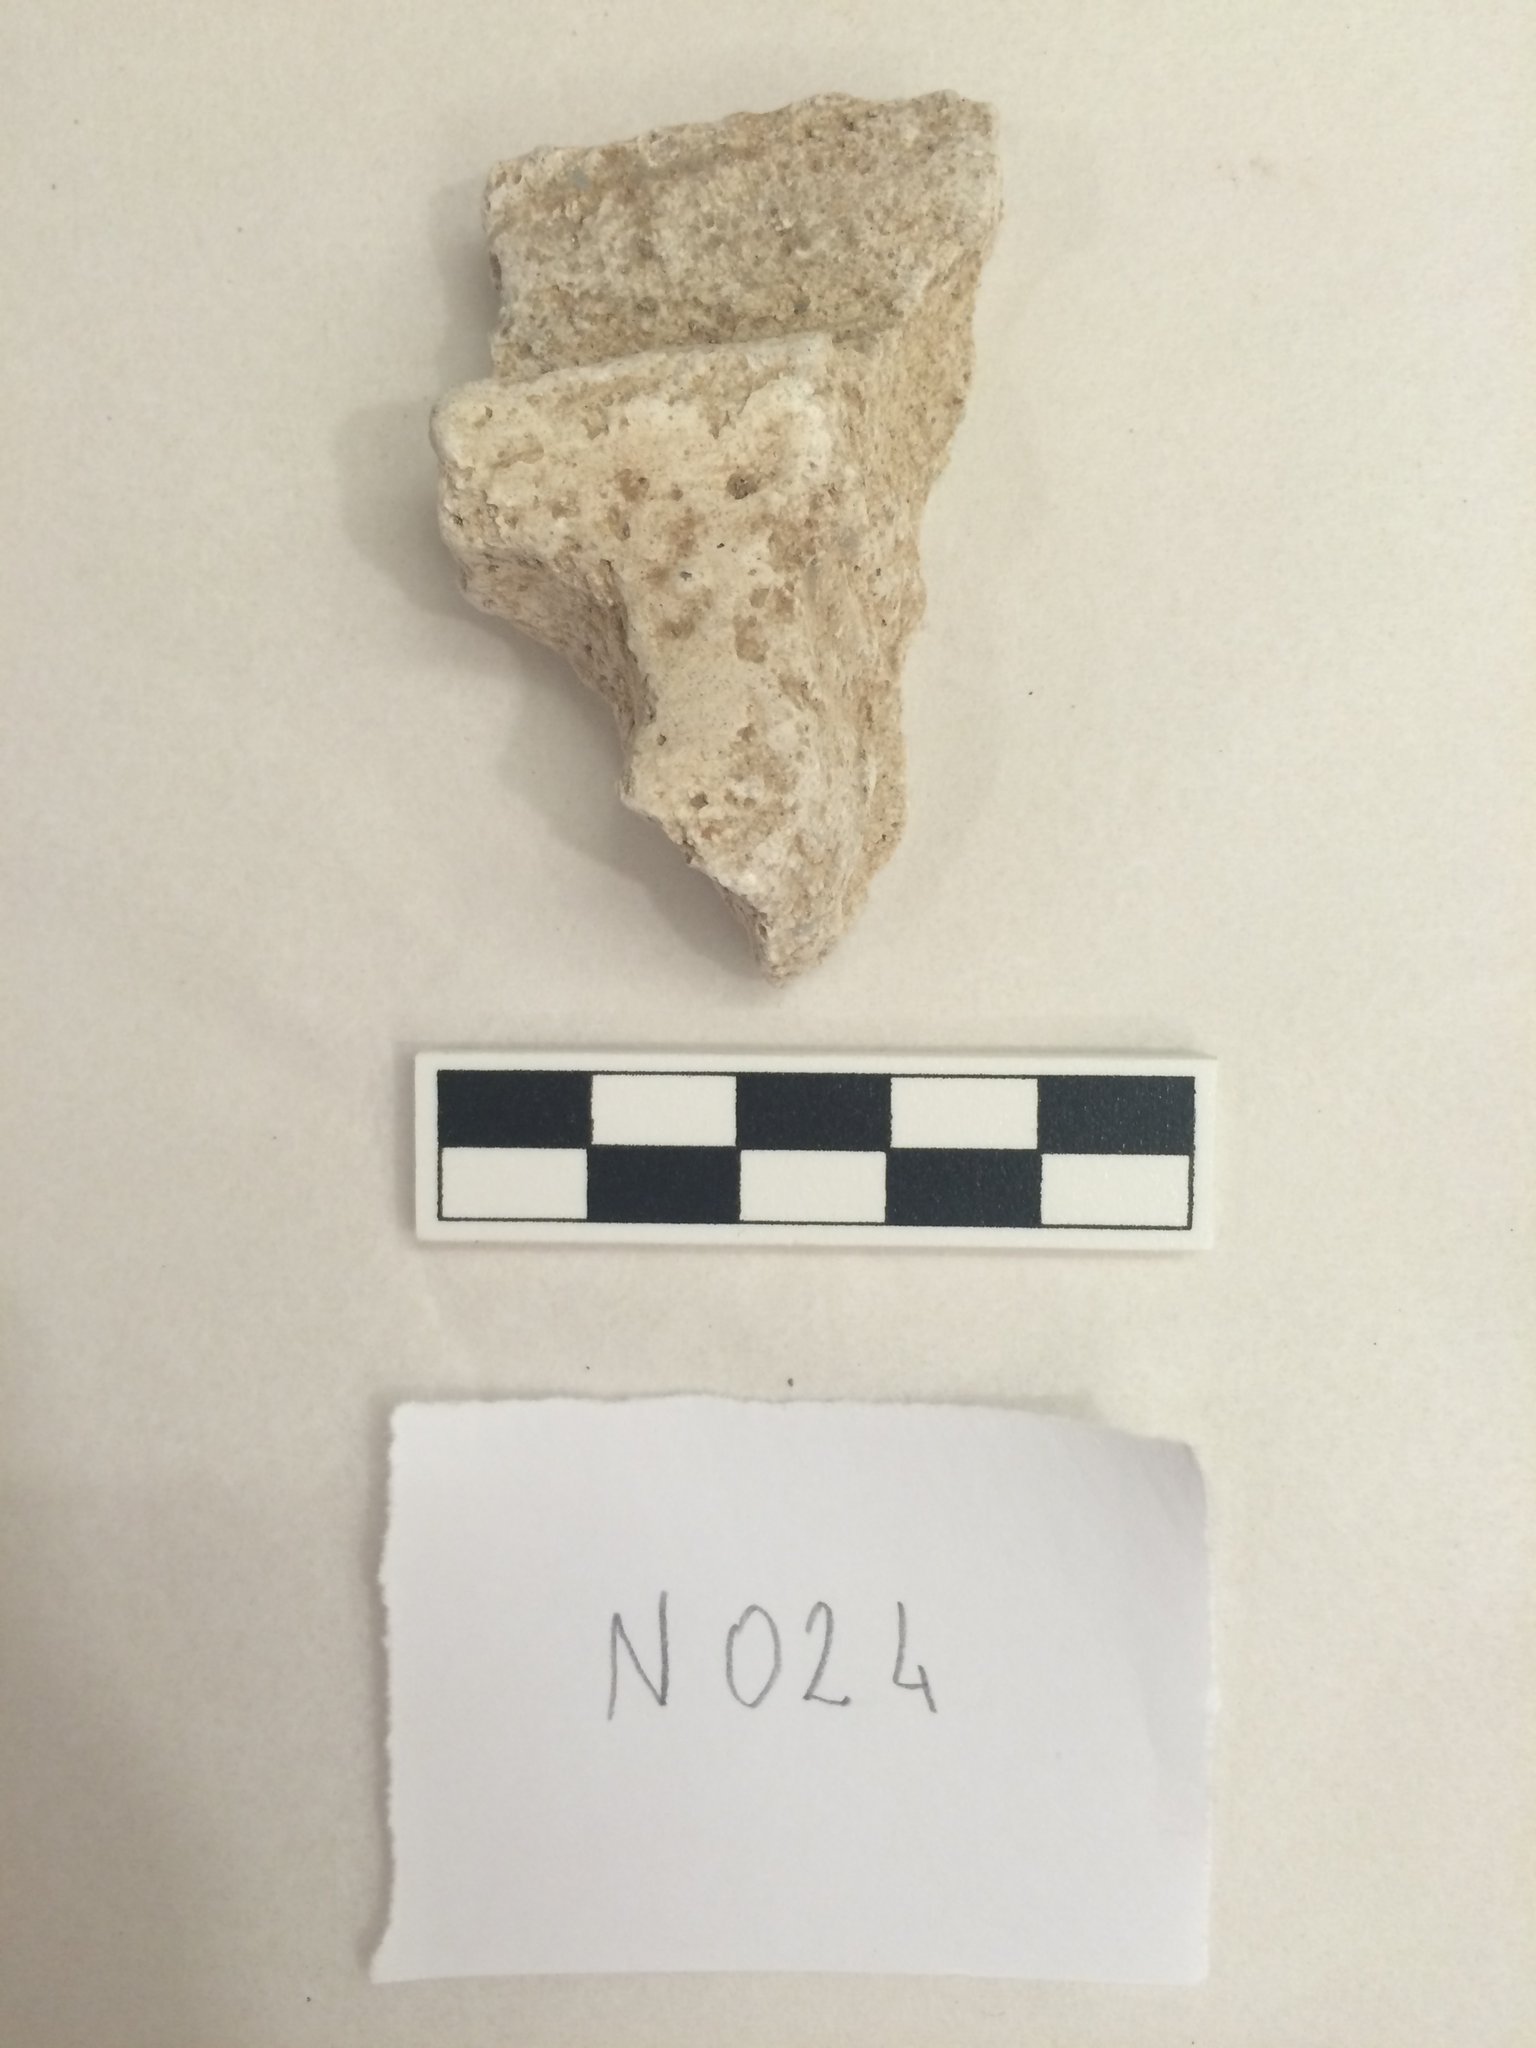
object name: fragment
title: Stucco Fragment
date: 701-1200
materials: plaster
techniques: carving, painting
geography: iran